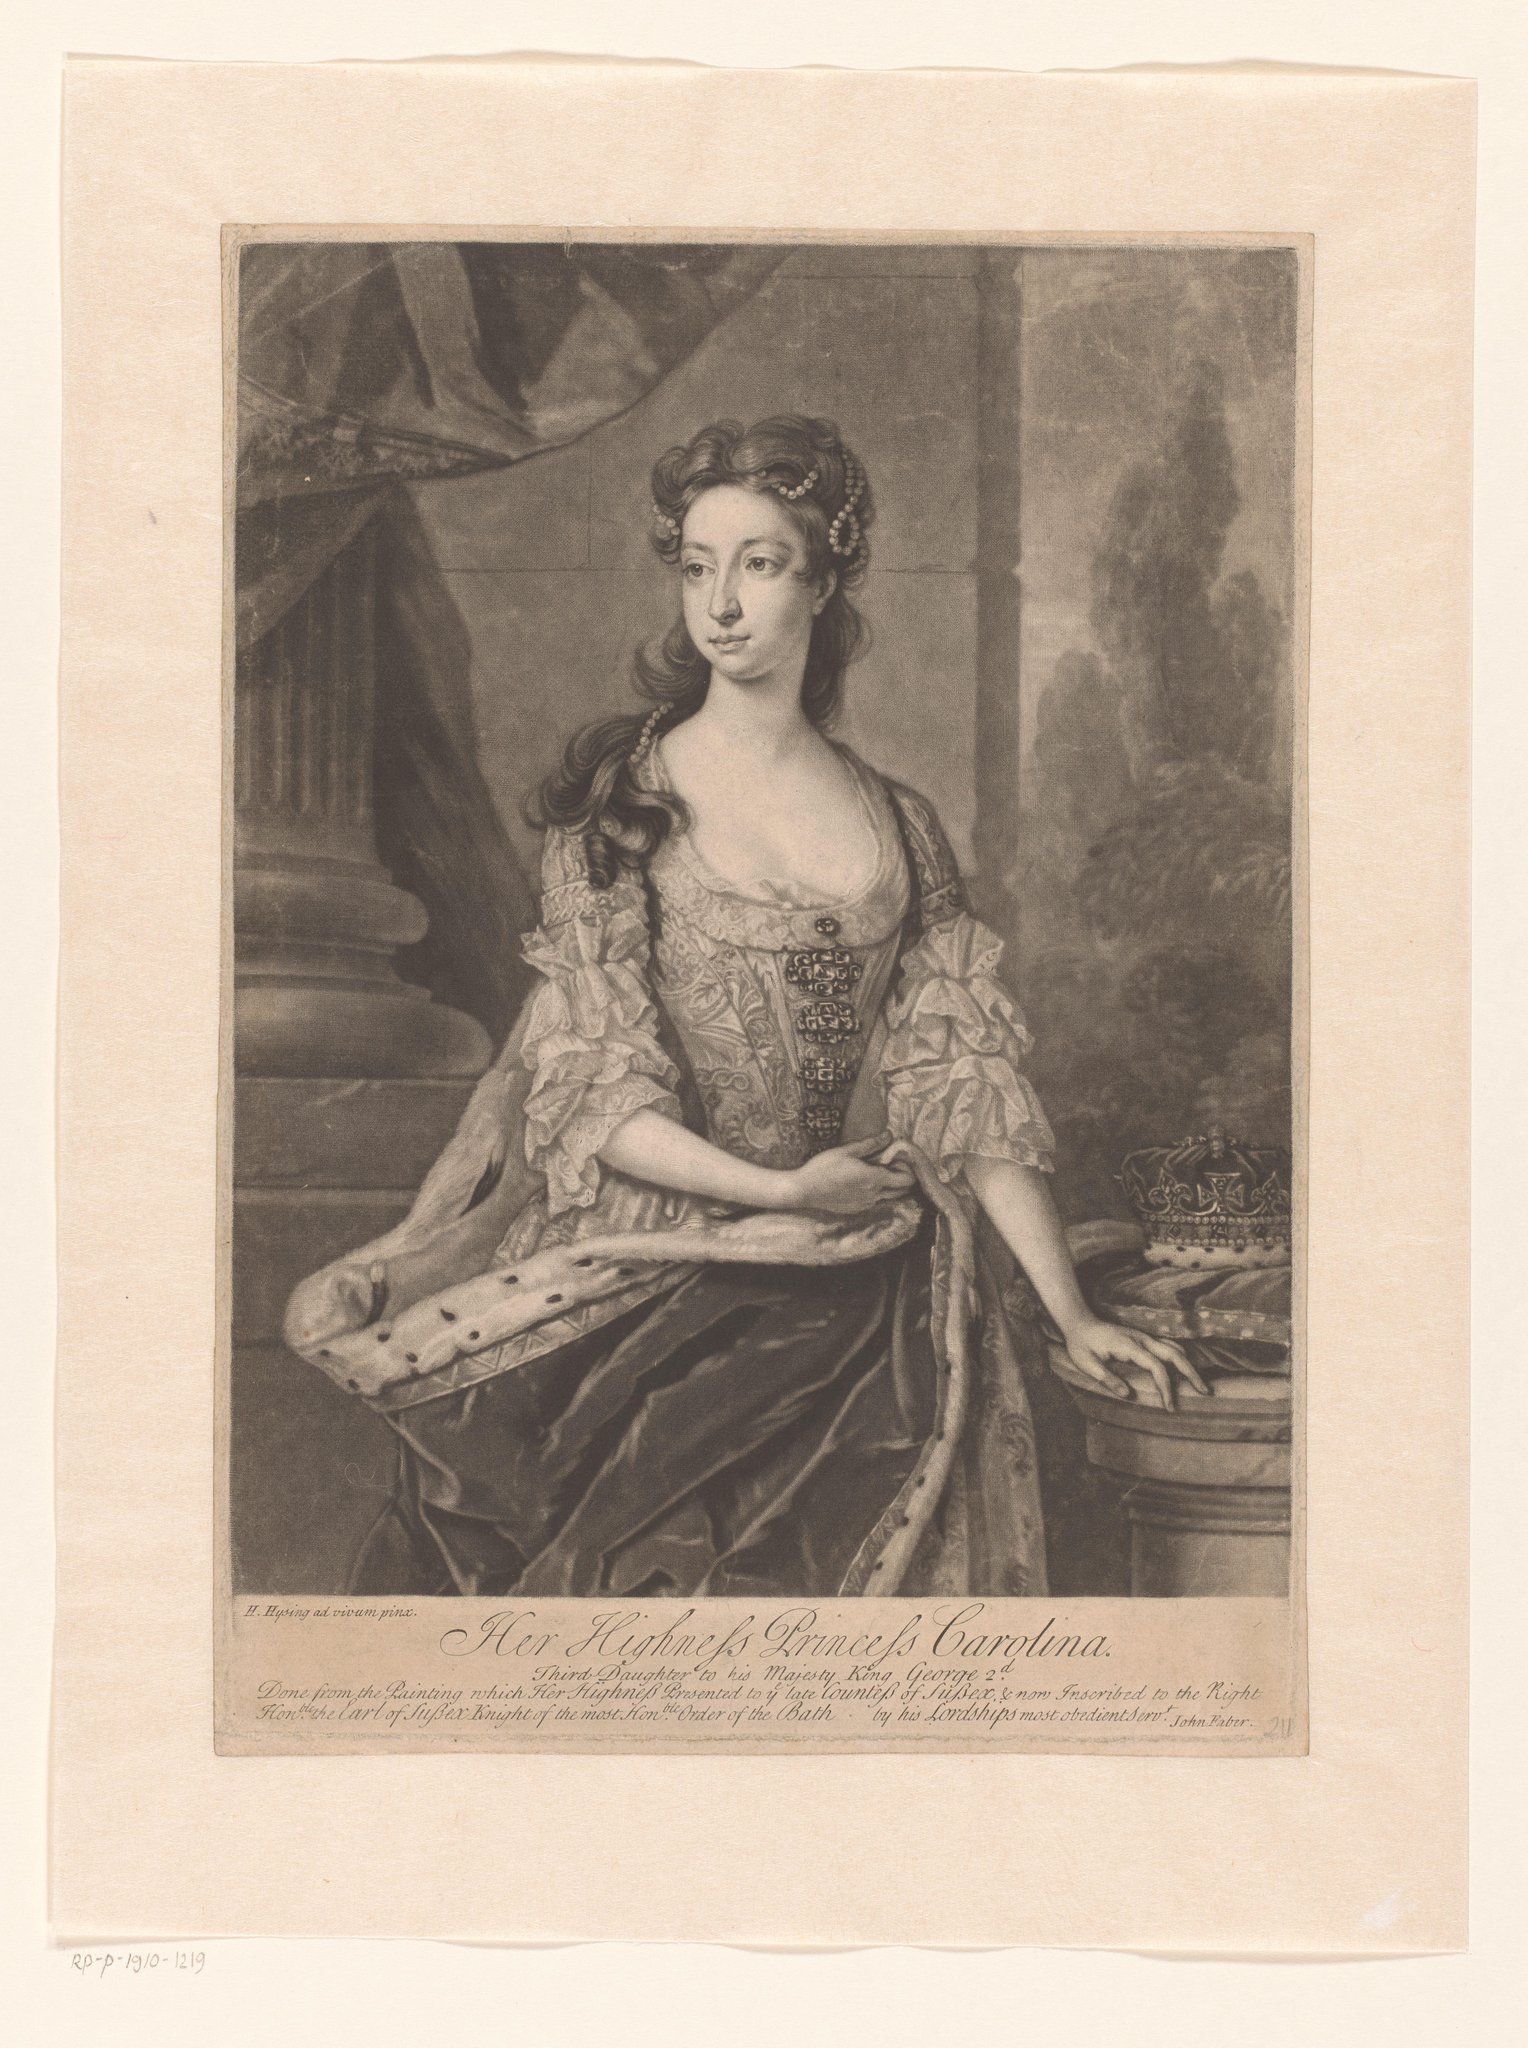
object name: print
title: Portret van Carolina van Hannover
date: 1723-1756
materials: paper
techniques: mezzotint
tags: london, historical persons, princess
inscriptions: collector's mark: Lugt 2228